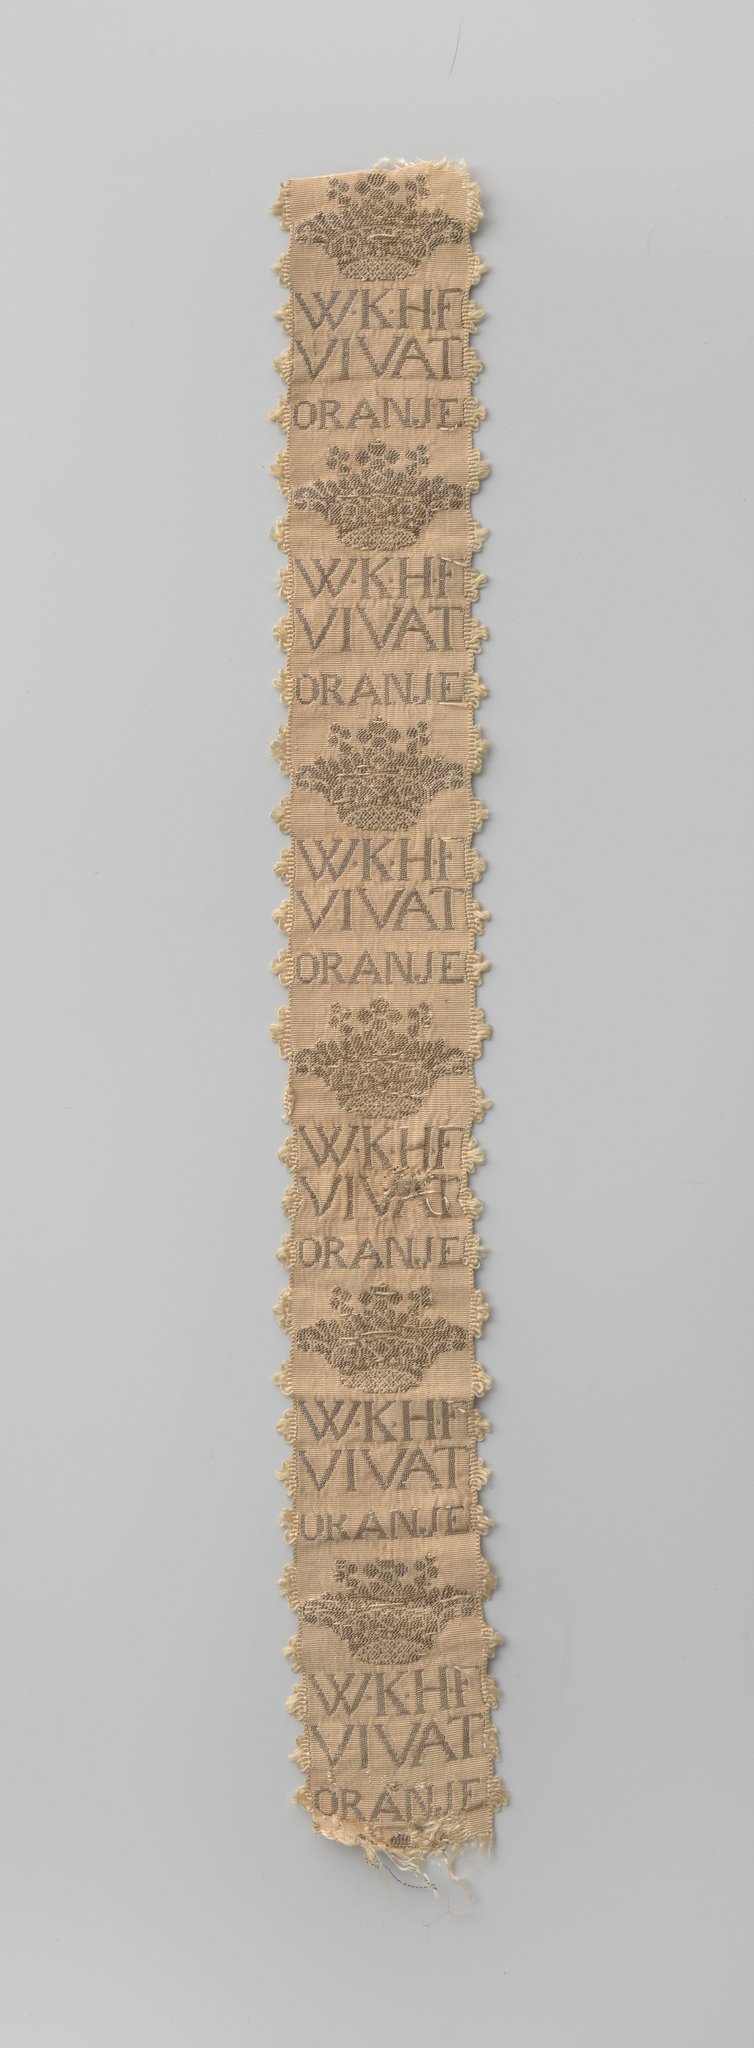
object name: ribbon material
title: Oranjelint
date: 1750-1800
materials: gold thread, silk, thread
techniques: stitching, weave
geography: netherlands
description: Dubbel lichtoranje lintje, aan de onderkant gevorkt in vier punten. Op het lint is een gele cartouche omgeven door zilveren, kant-achtige franje, gestikt, die het grootste deel van het lint bedekt. Hierop het wapen van Oranje-Nassau omgeven door lichtblauwe kousenband en erboven een gouden kroon. Eronder een cartouche met lichtblauwe geschulpte rand waarin opschrift in het zwart: VIVAT / PRINS / VAN / ORANiE. Randschrift; kousenband: HONI SOIT QVI MAL Y PENSE.